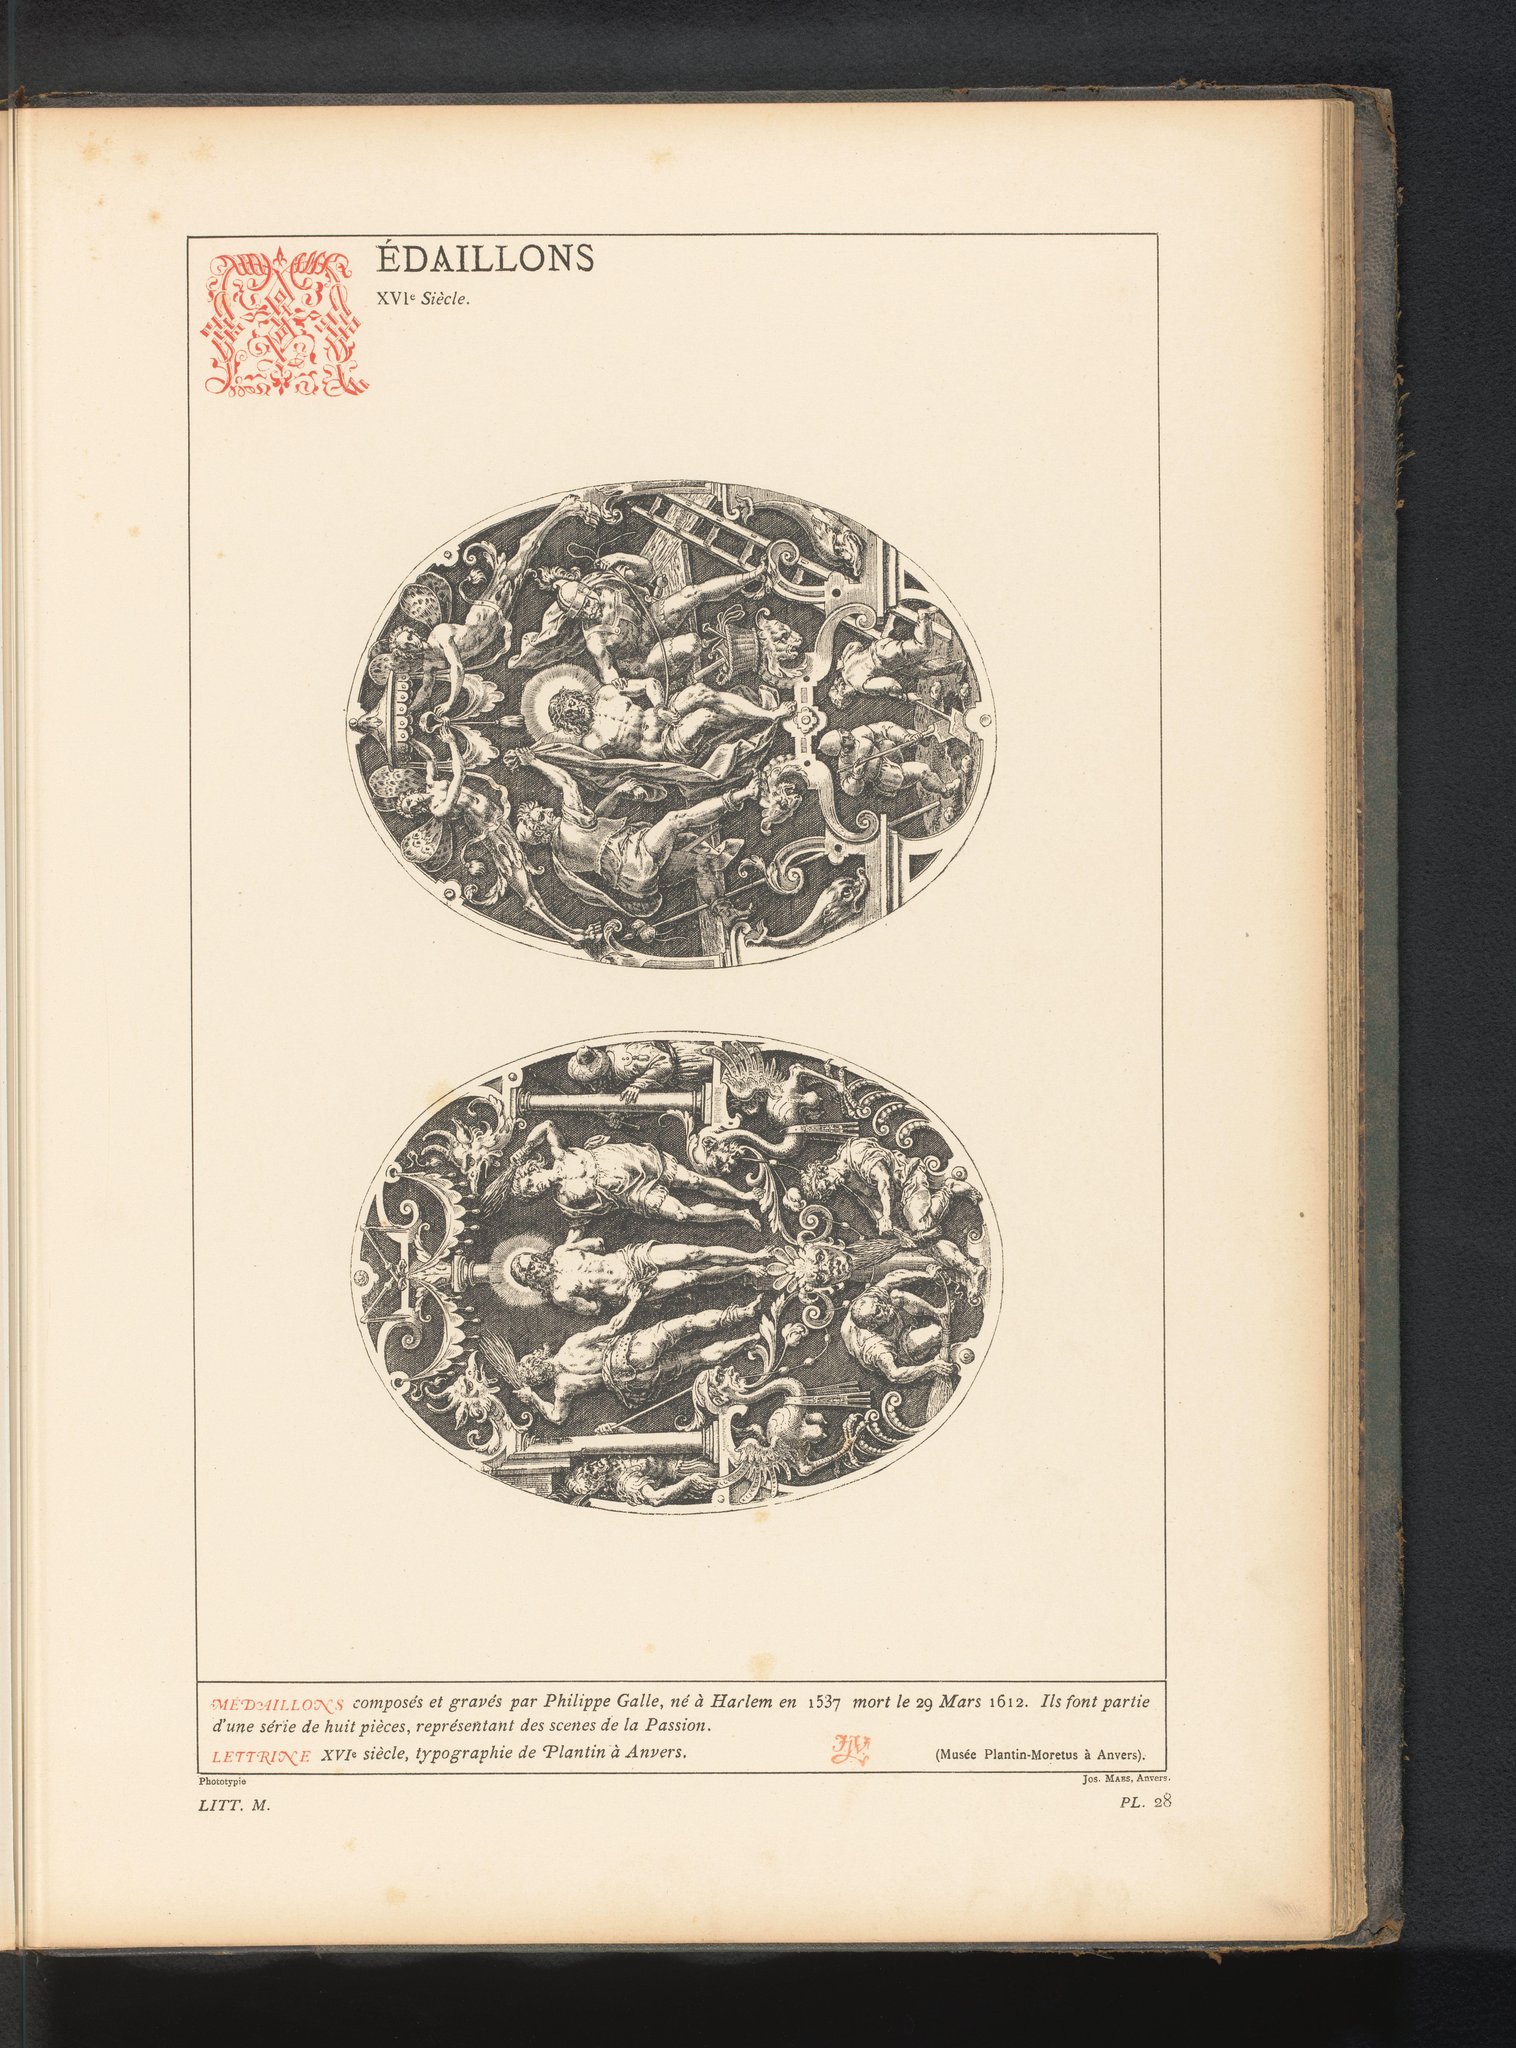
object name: page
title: Médaillons, XVIe Siècle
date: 1875-1880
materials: paper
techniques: photolithography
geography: antwerp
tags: ornament ~ medallion, passion of christ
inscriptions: monogram: ‘JJvY’, inscription: ‘MÉDAILLONS composés et (...)’, inscription: ‘LITT. M. - PL. 28’